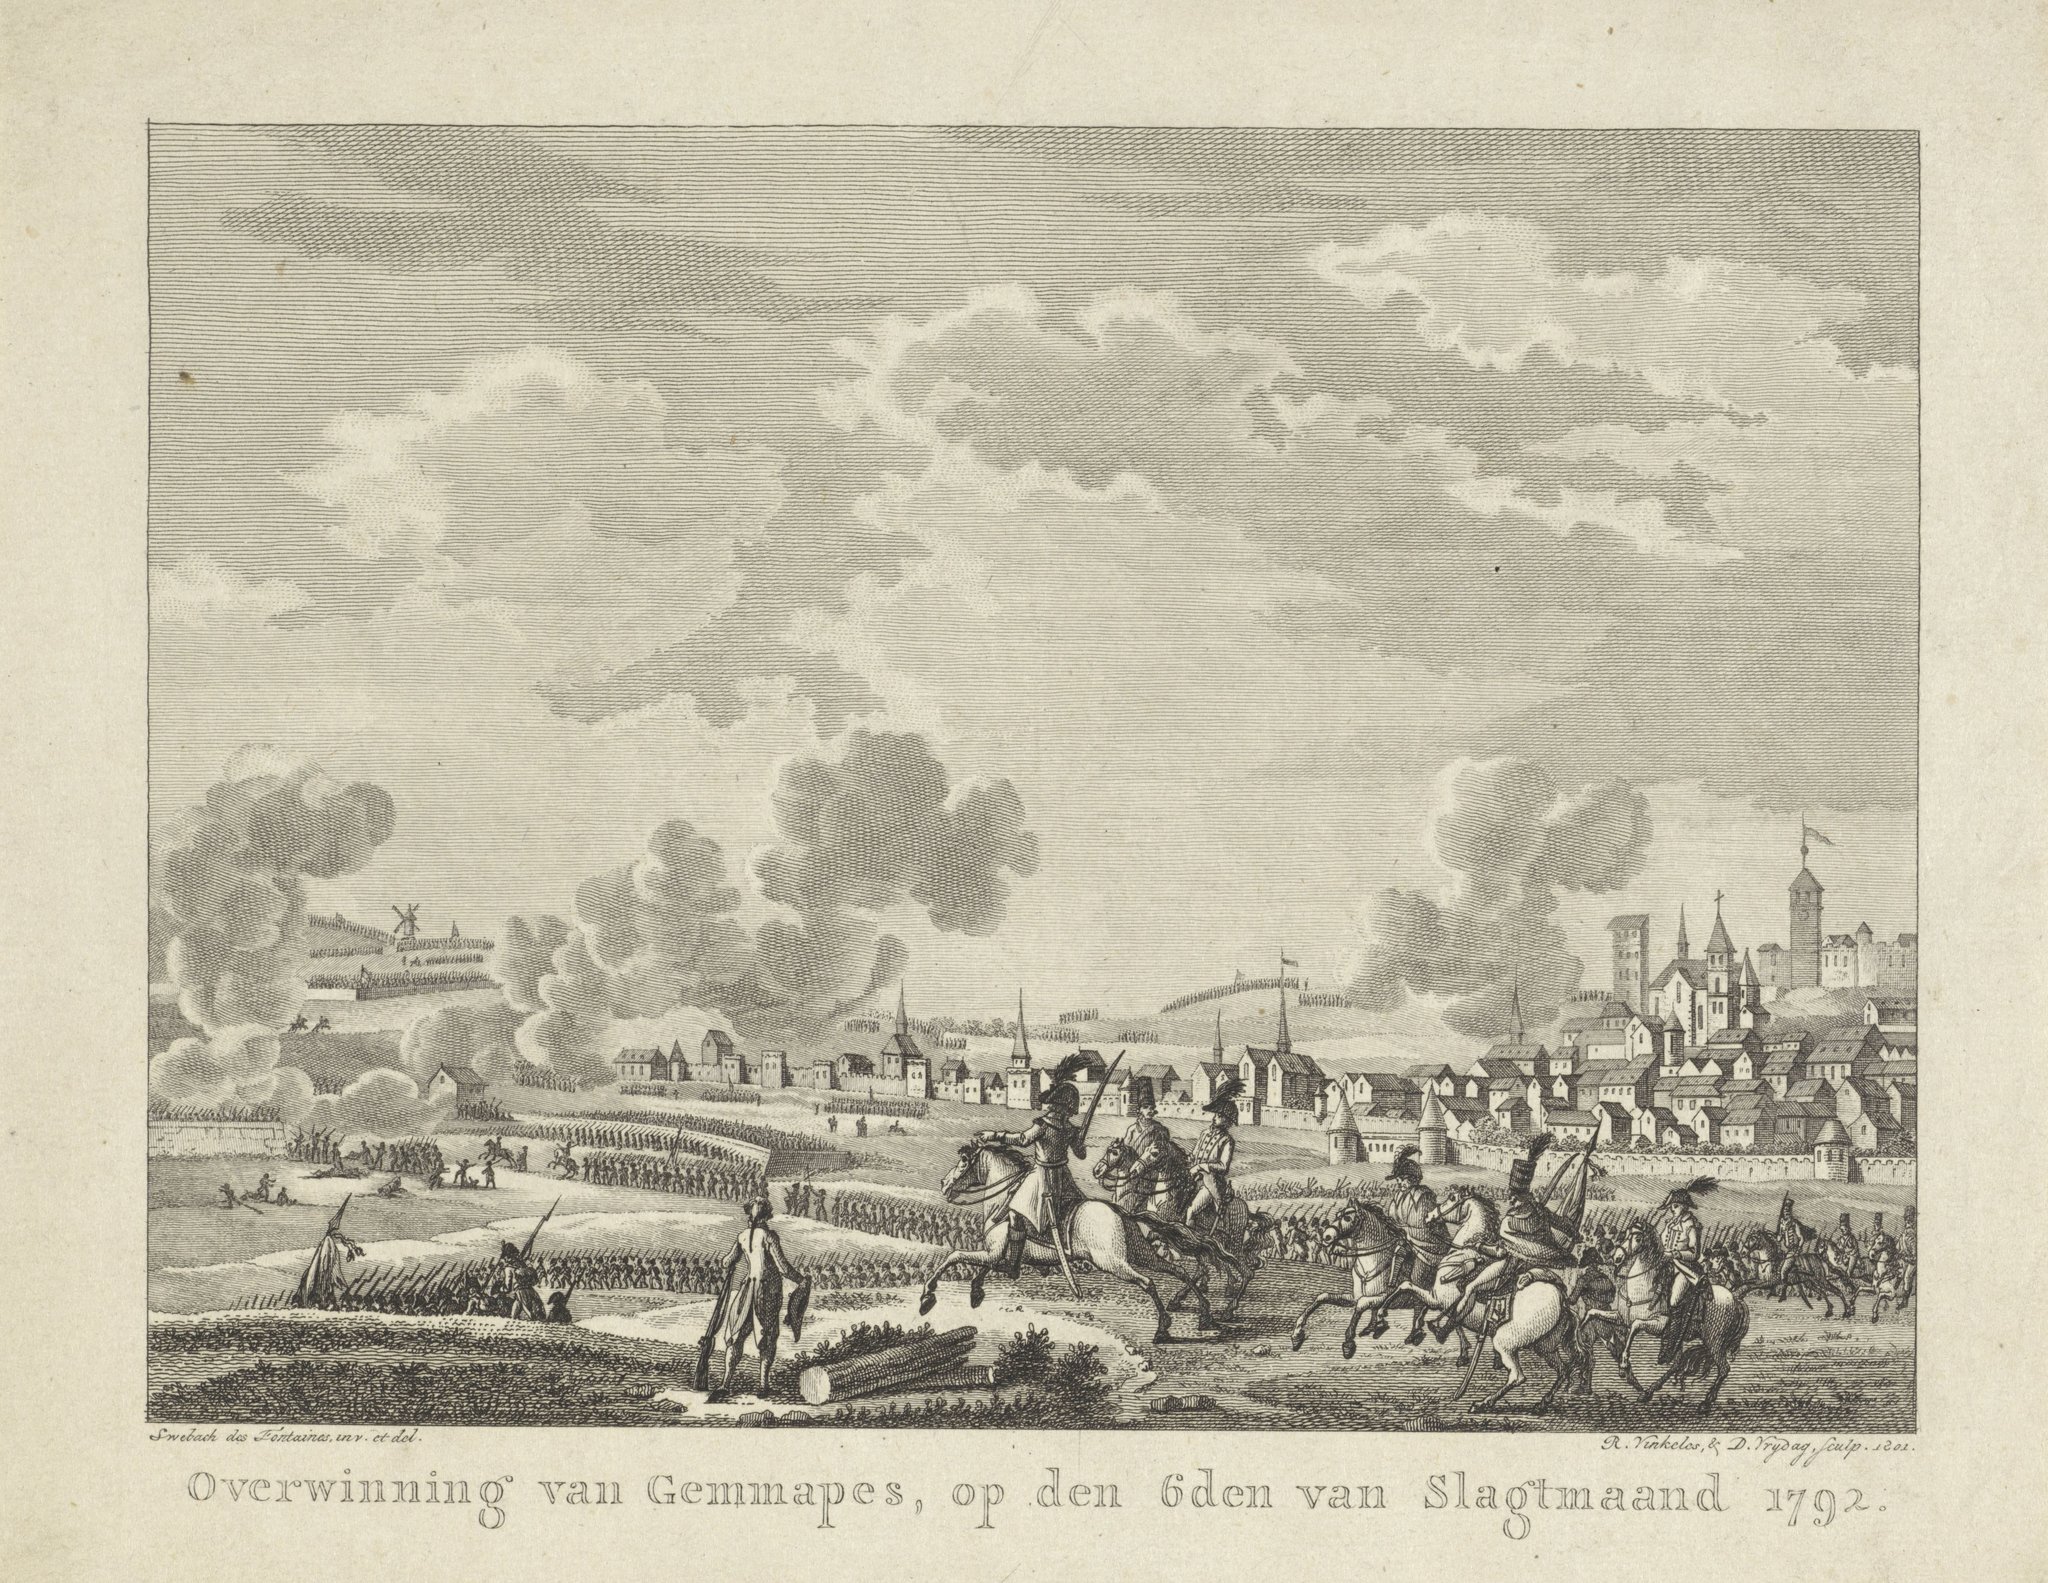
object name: history print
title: Overwinning van Gemmapes, op den 6den van Slagtmaand 1792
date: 1801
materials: paper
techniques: engraving, etching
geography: amsterdam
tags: battle (+ land forces)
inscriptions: collector's mark: Lugt 2228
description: Slag bij Jemappes in Henegouwen met een overwinning van de Franse revolutionaire troepen onder generaal Charles-François Dumouriez op het Oostenrijkse leger, 6 november 1792.